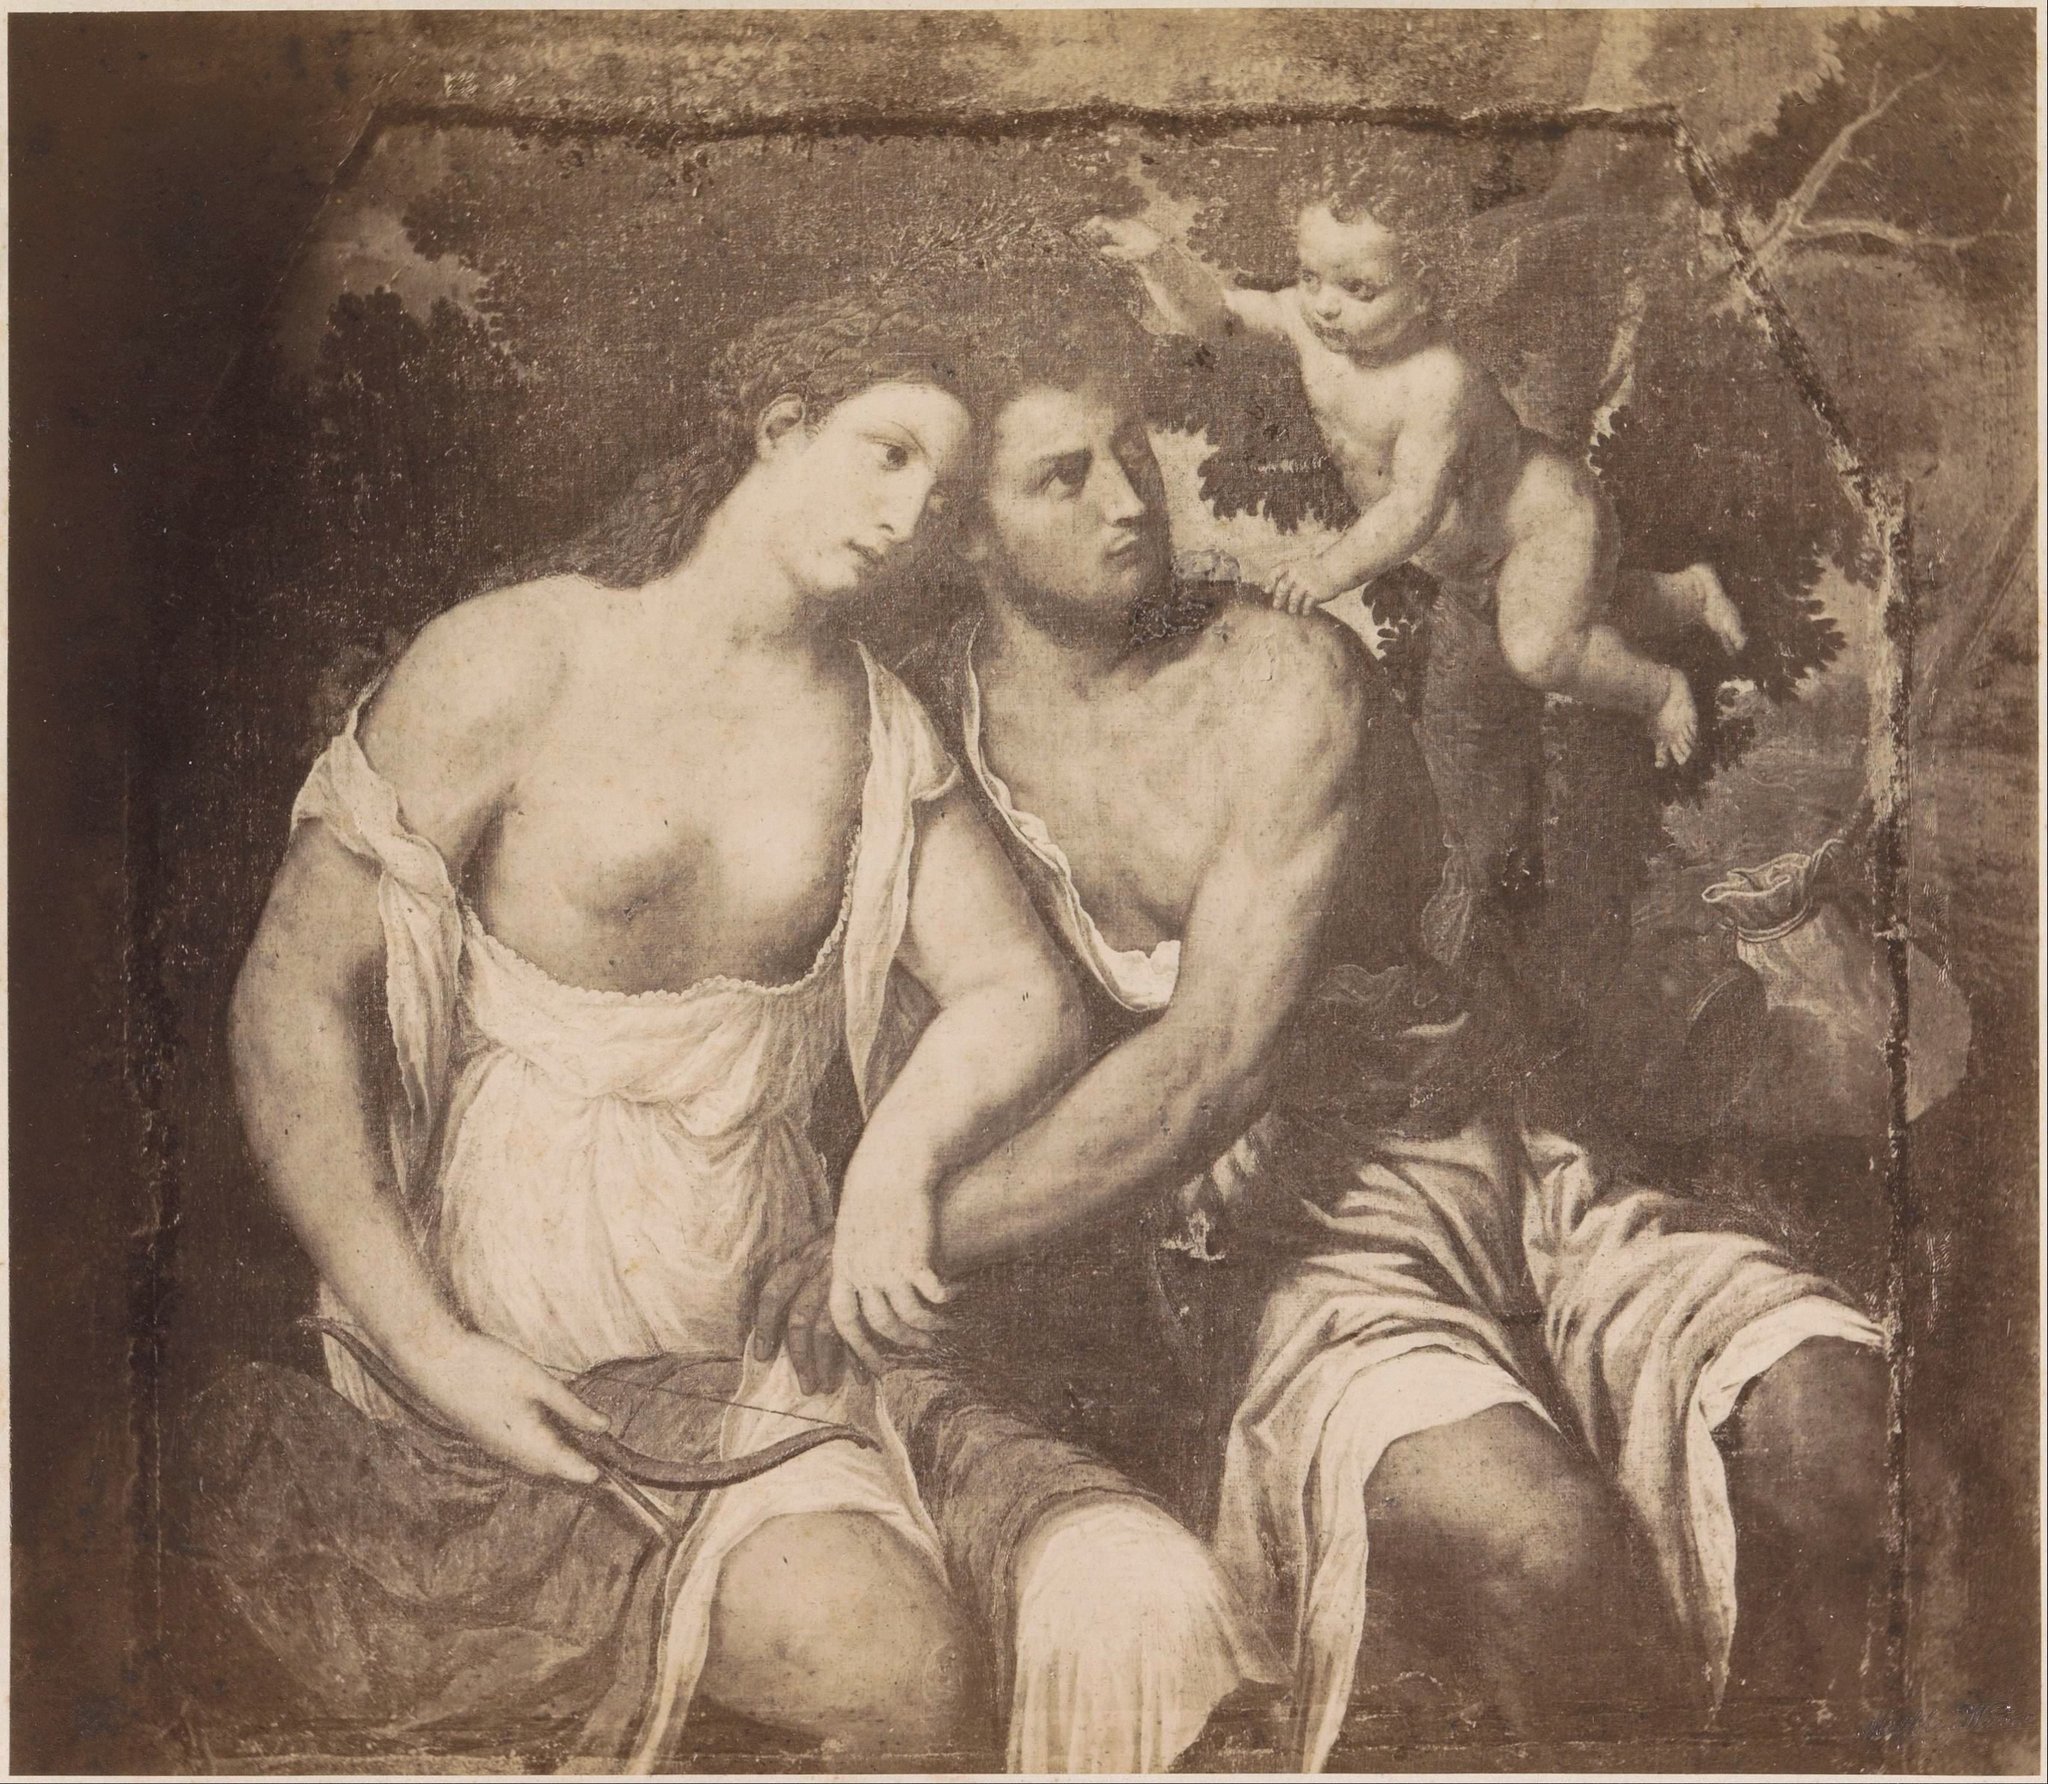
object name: reproduction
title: Paris Bordone. Venus und Adonis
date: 1861-1874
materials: cardboard, paper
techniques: albumen print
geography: vienna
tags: picture, painting, venus and adonis as lovers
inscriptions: inscription: ‘VERVIELFÄLTIGUNG VORBEHALTEN.’, number: ‘154.’, inscription: ‘AUF LEINWAND. 108 CTM., 126 CTM.’, inscription: ‘MIT K.K. AUSSCHLIESS PRIVILEGIUM’, collector's mark: ‘VOSMAER’